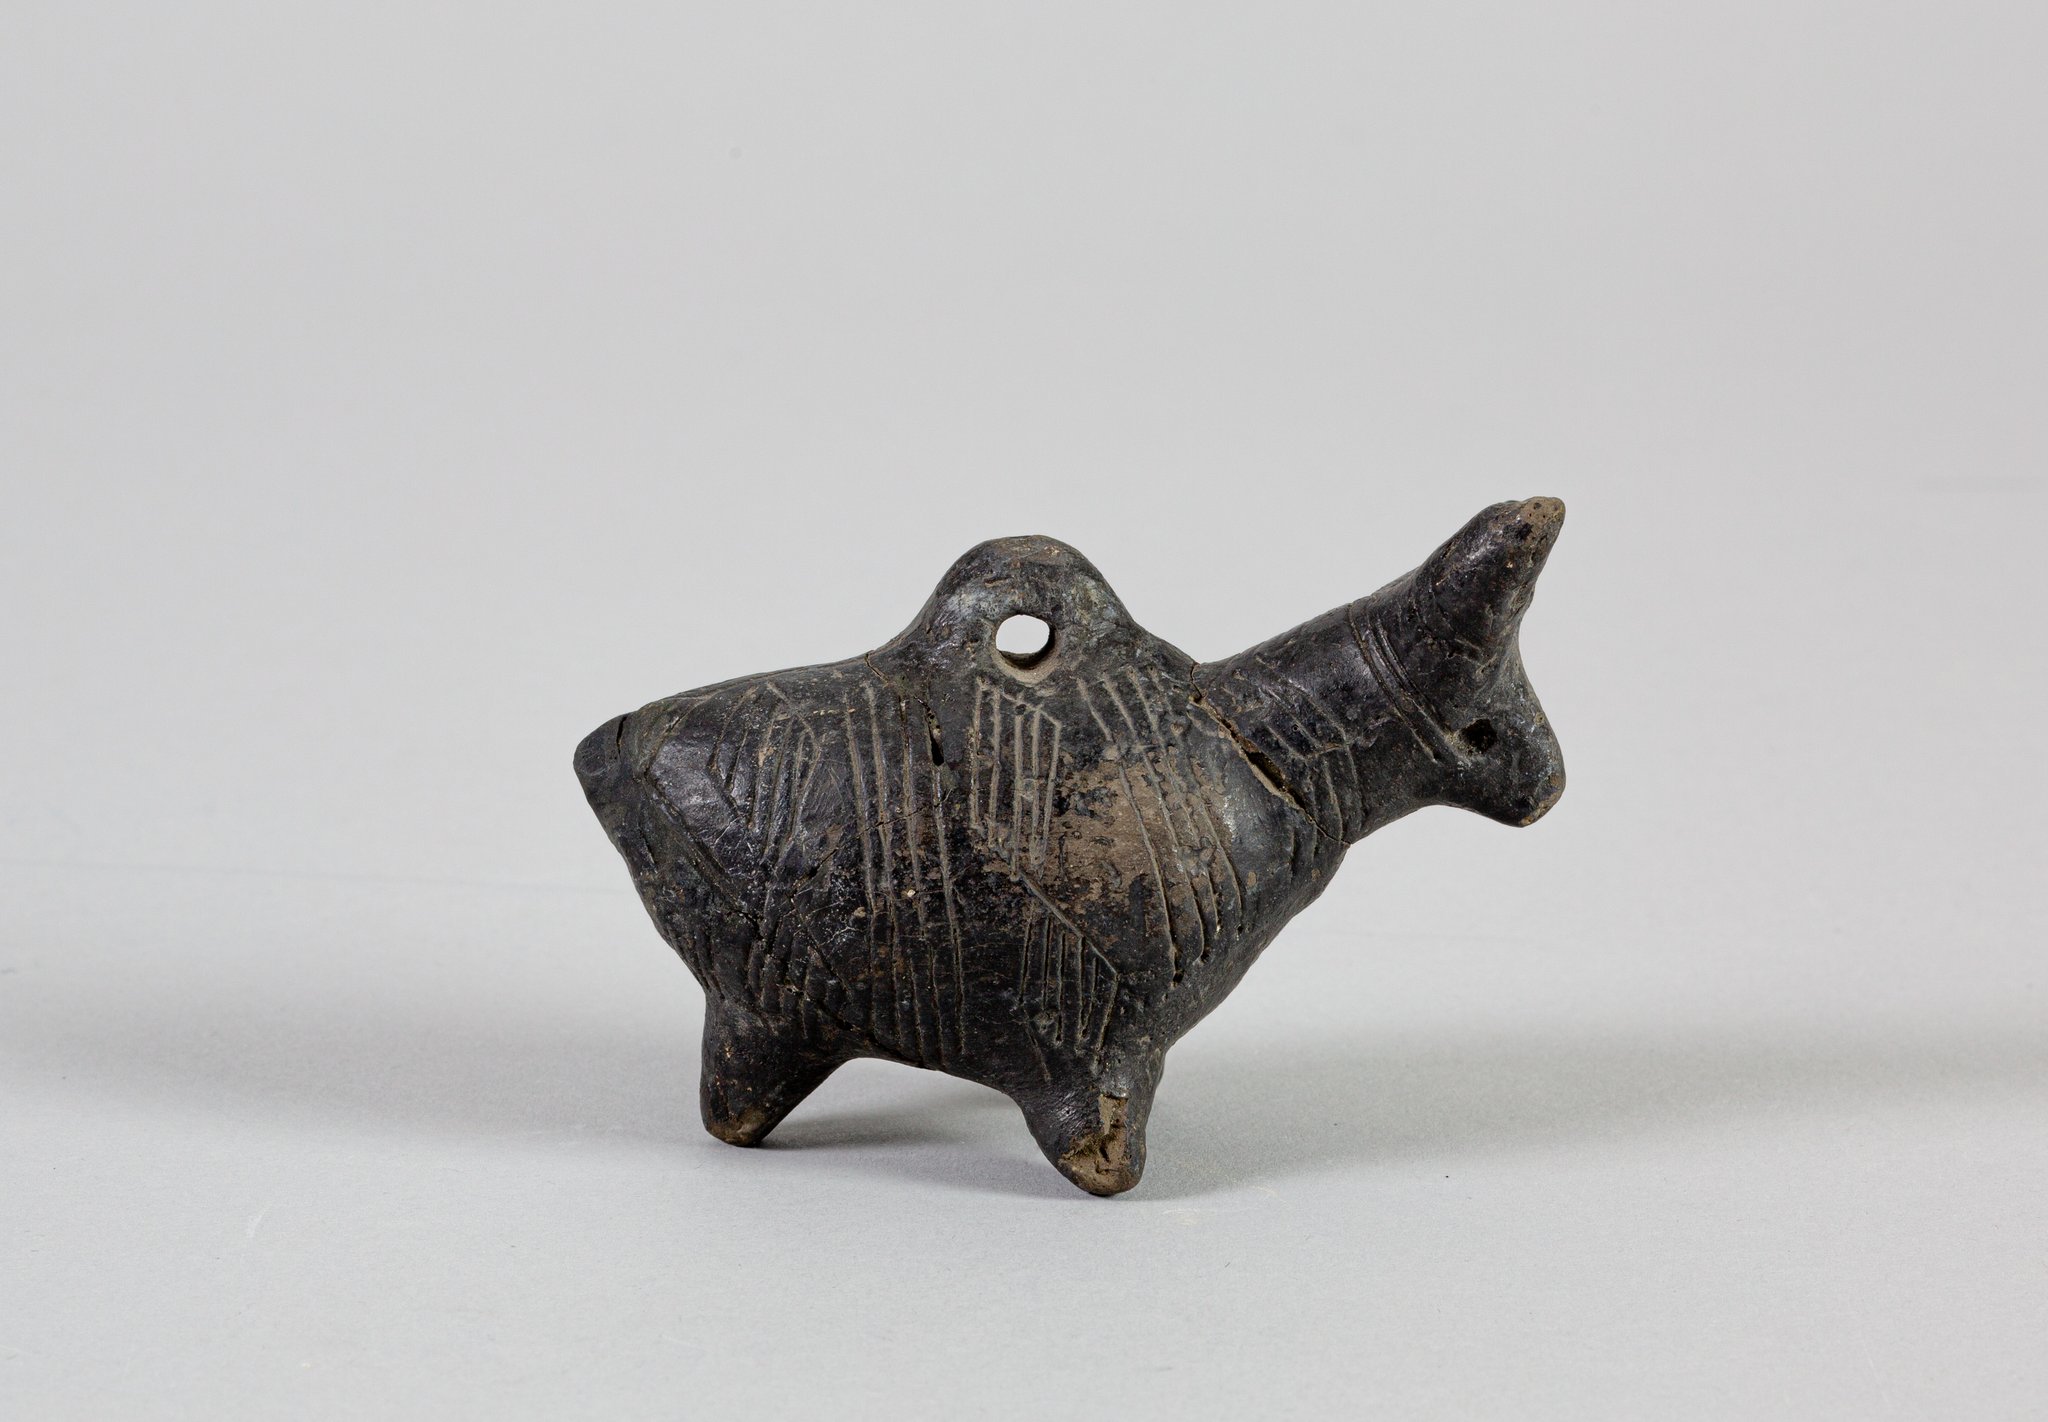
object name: askos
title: Terracotta askos in the shape of a quadruped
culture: cypriot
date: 2000-1725 BCE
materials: terracotta